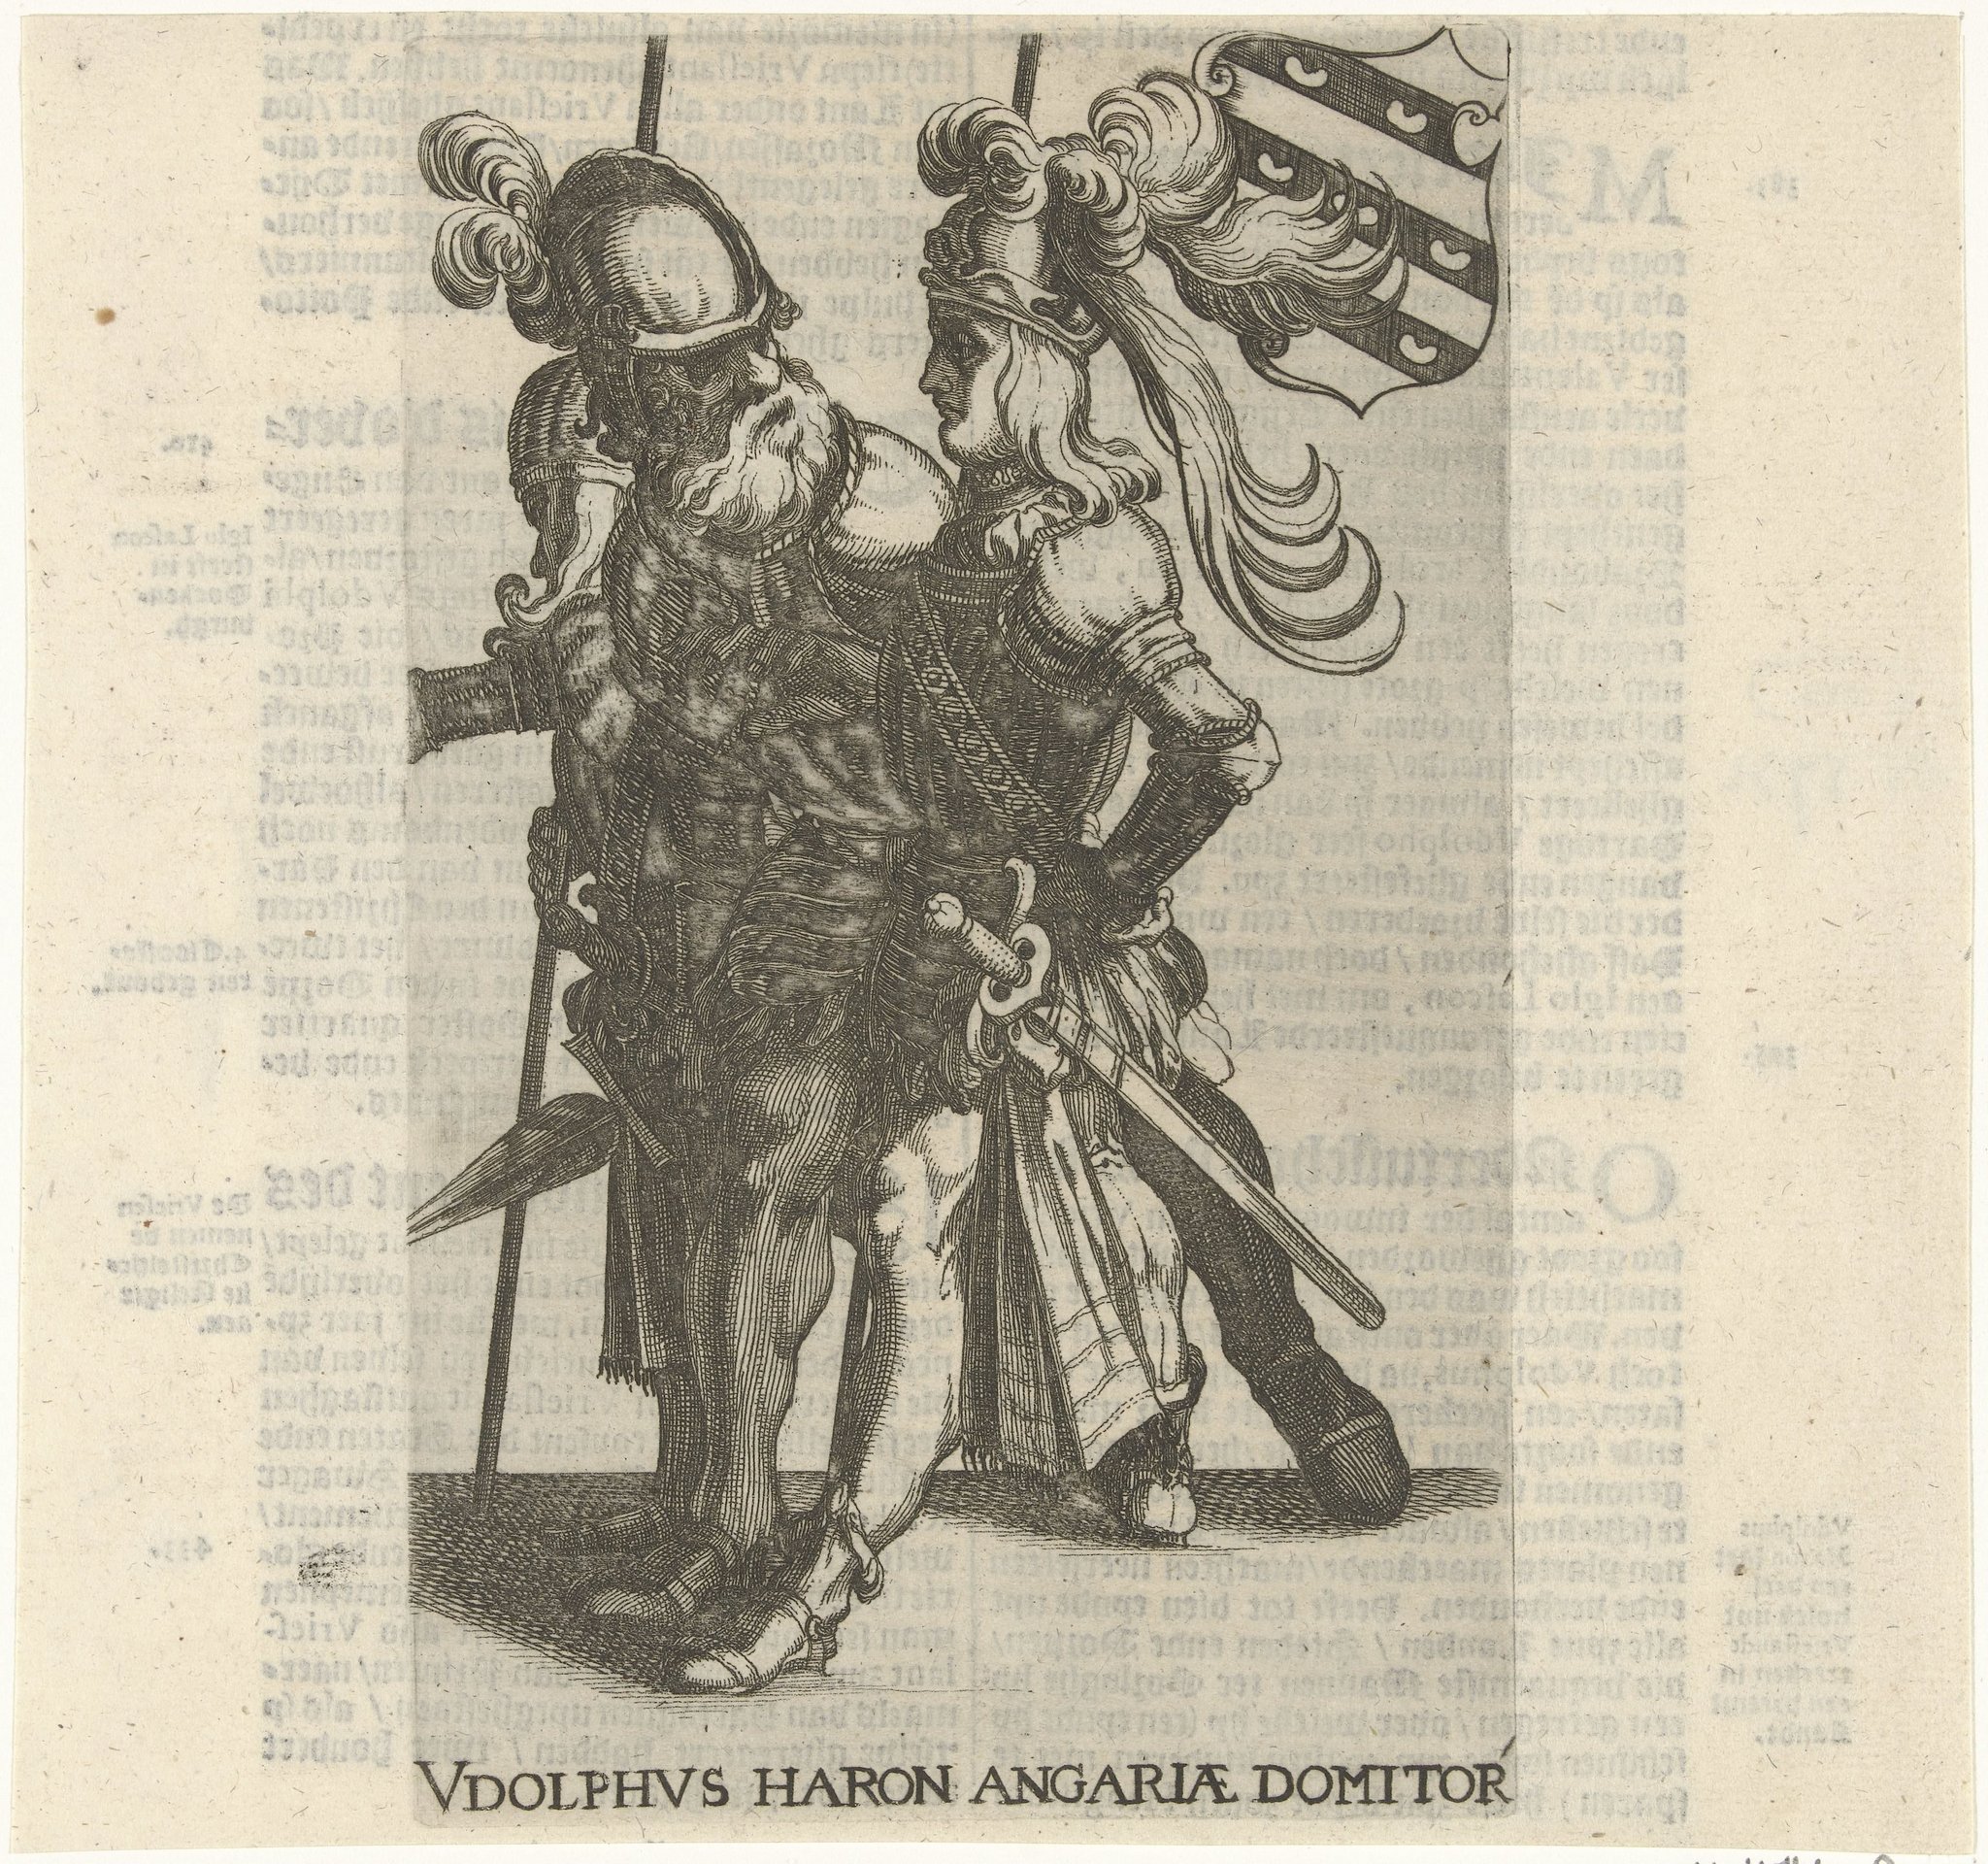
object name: print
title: Udolphus Haron angariae domitor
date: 1622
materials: paper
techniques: etching, letterpress printing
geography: franeker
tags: udolf haron (hertog der friezen)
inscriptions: collector's mark: Lugt 2228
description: De prent is ook als boekillustratie gebruikt in: Winsemius, P.W. Chronique ofte Historische geschiedenisse van Vrieslant (...). Franeker: Joannes Lamrinck, 1622.